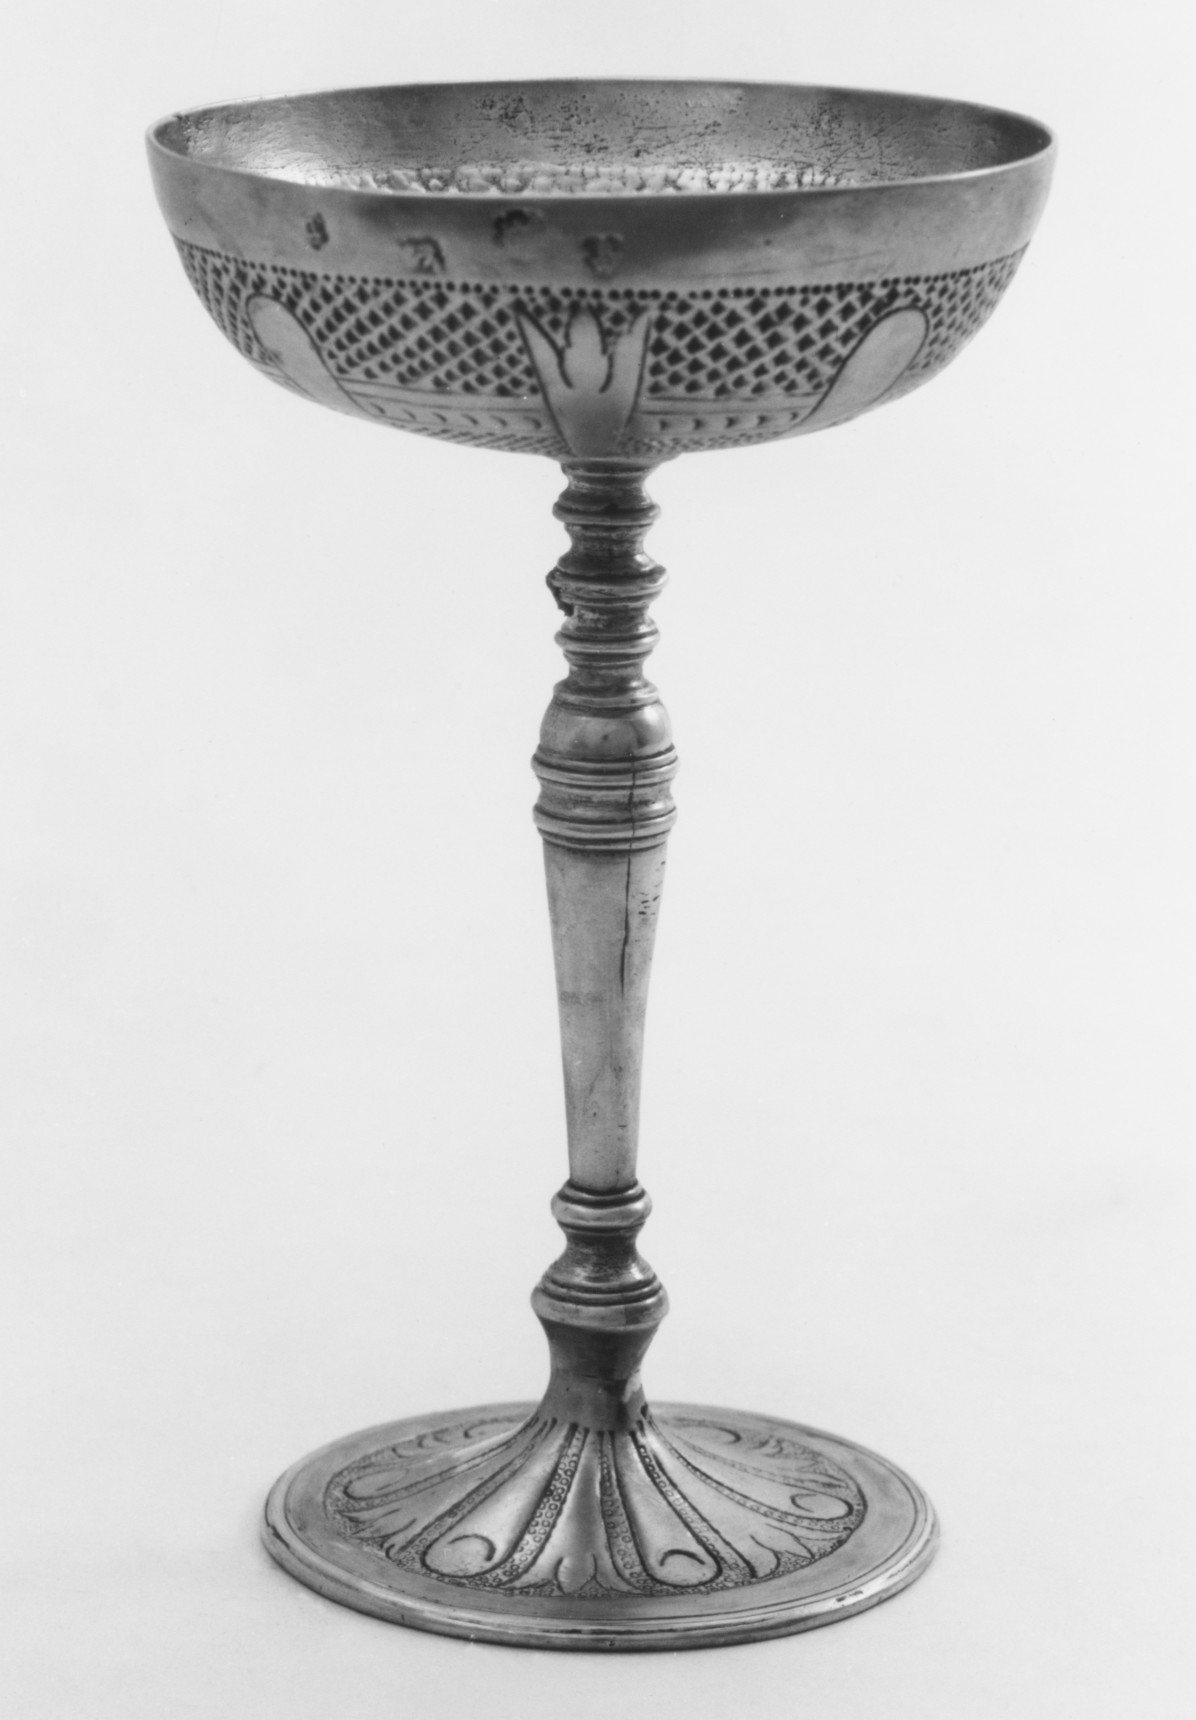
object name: wine cup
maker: r. w., london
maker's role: maker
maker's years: 1618-1619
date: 1618-1619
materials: silver